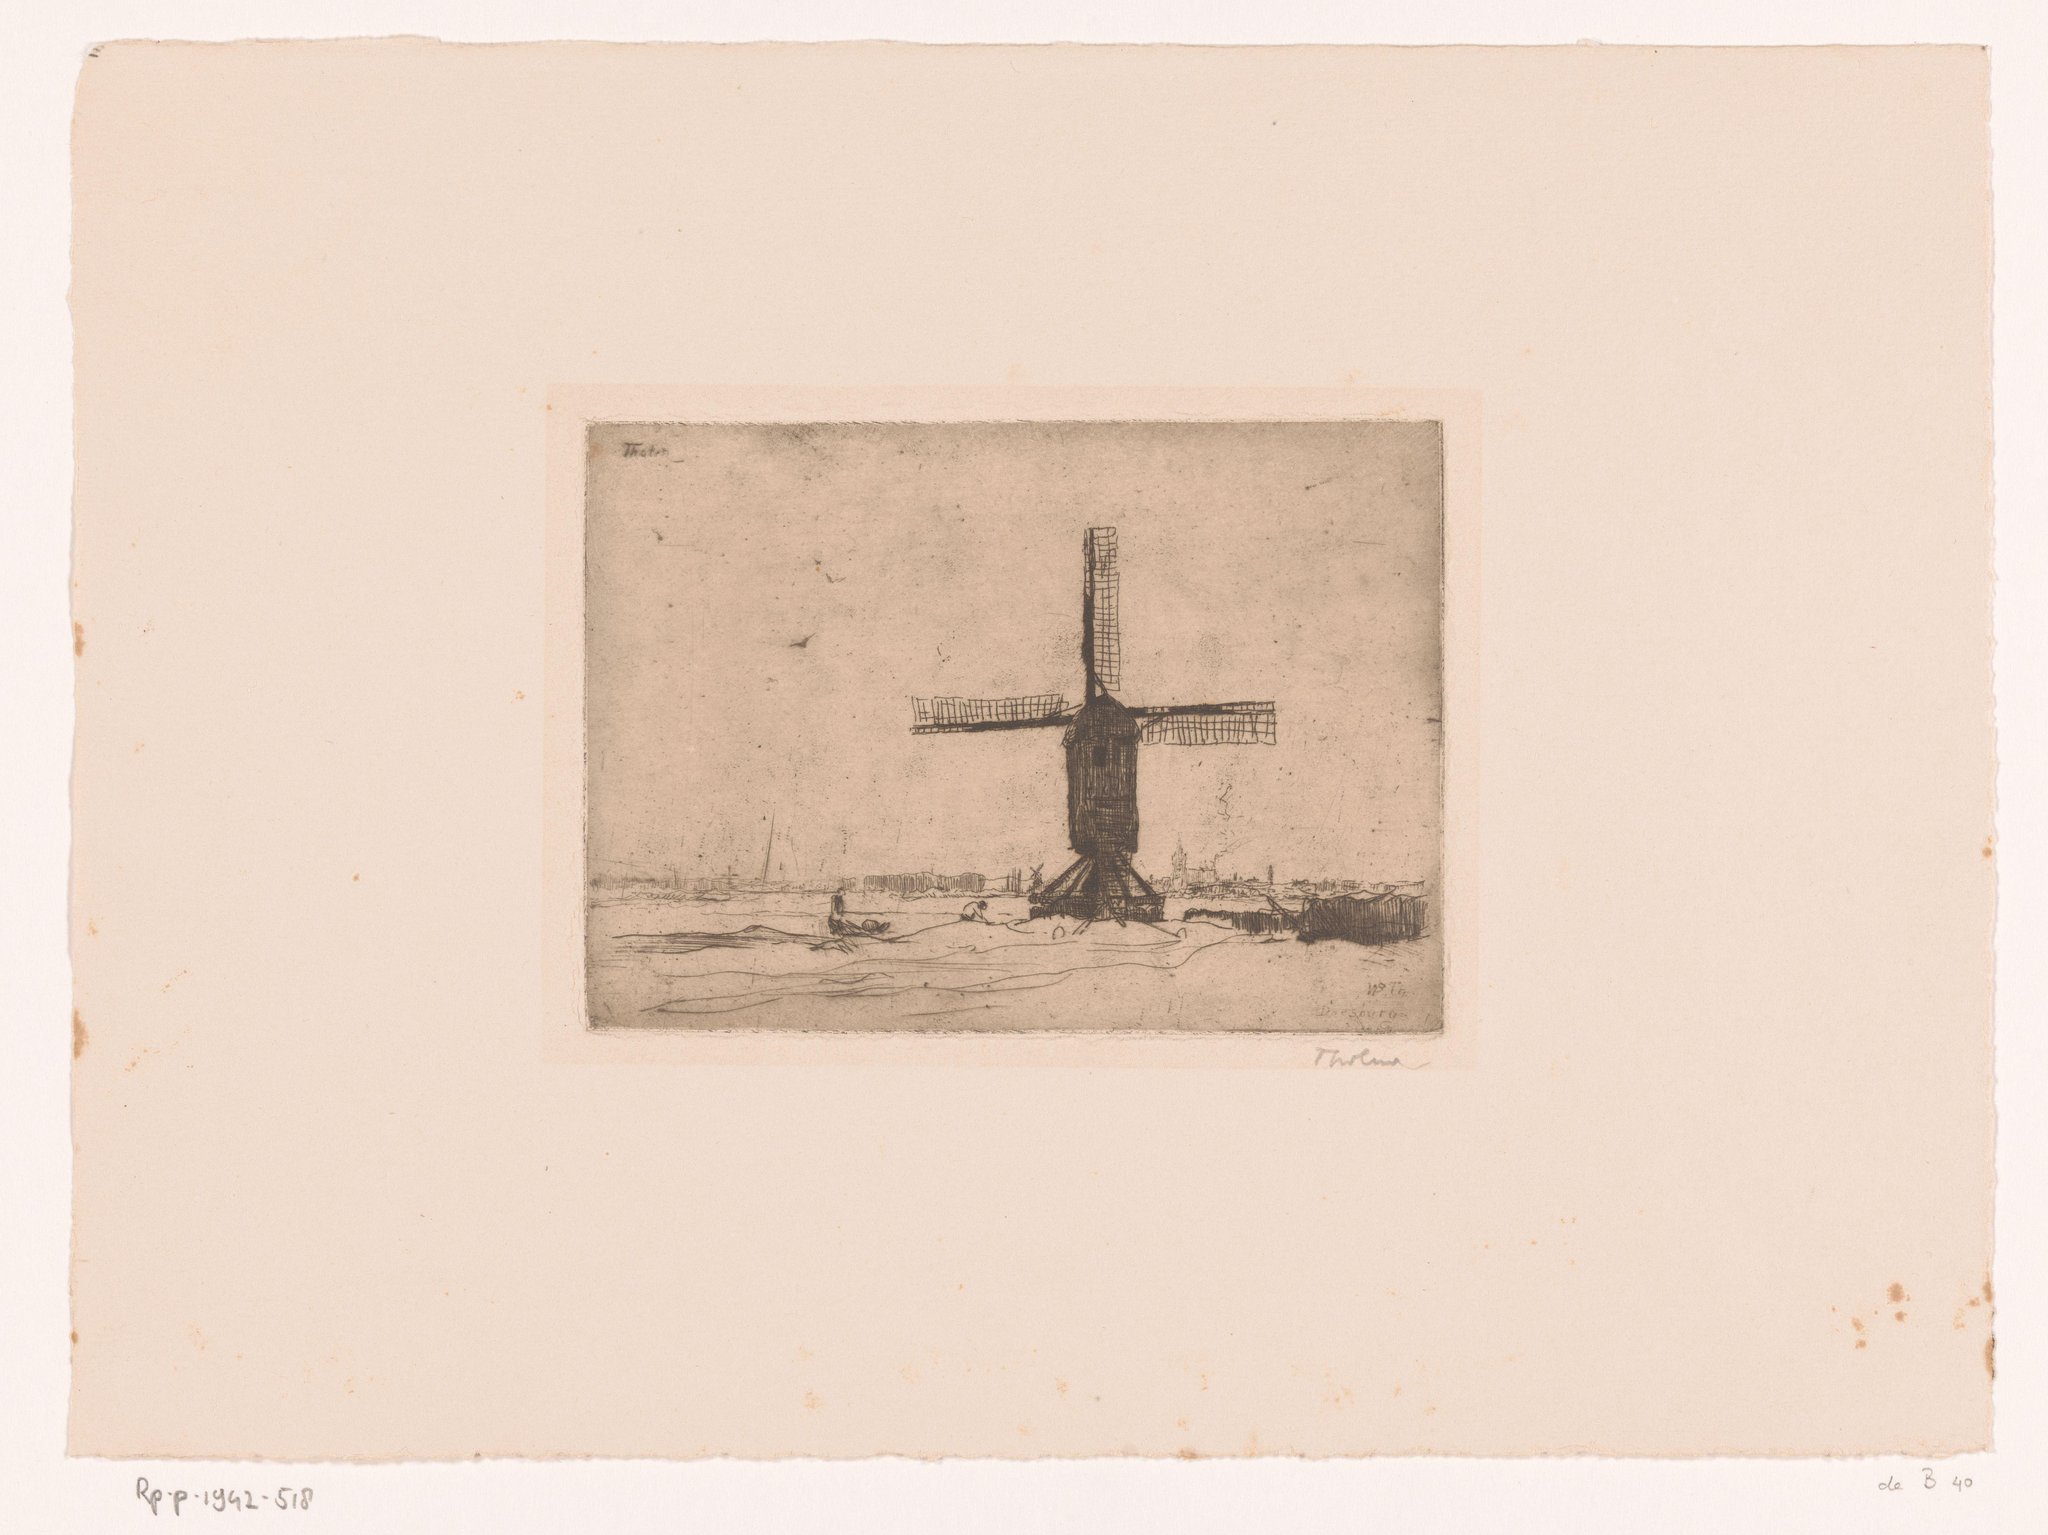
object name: print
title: Doesburgermolen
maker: willem bastiaan tholen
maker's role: draughtsman, painter, print maker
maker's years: 1860-1931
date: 1870-1914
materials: paper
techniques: drypoint, etching, intaglio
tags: lake, windmill in landscape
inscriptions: collector's mark: Lugt 2228